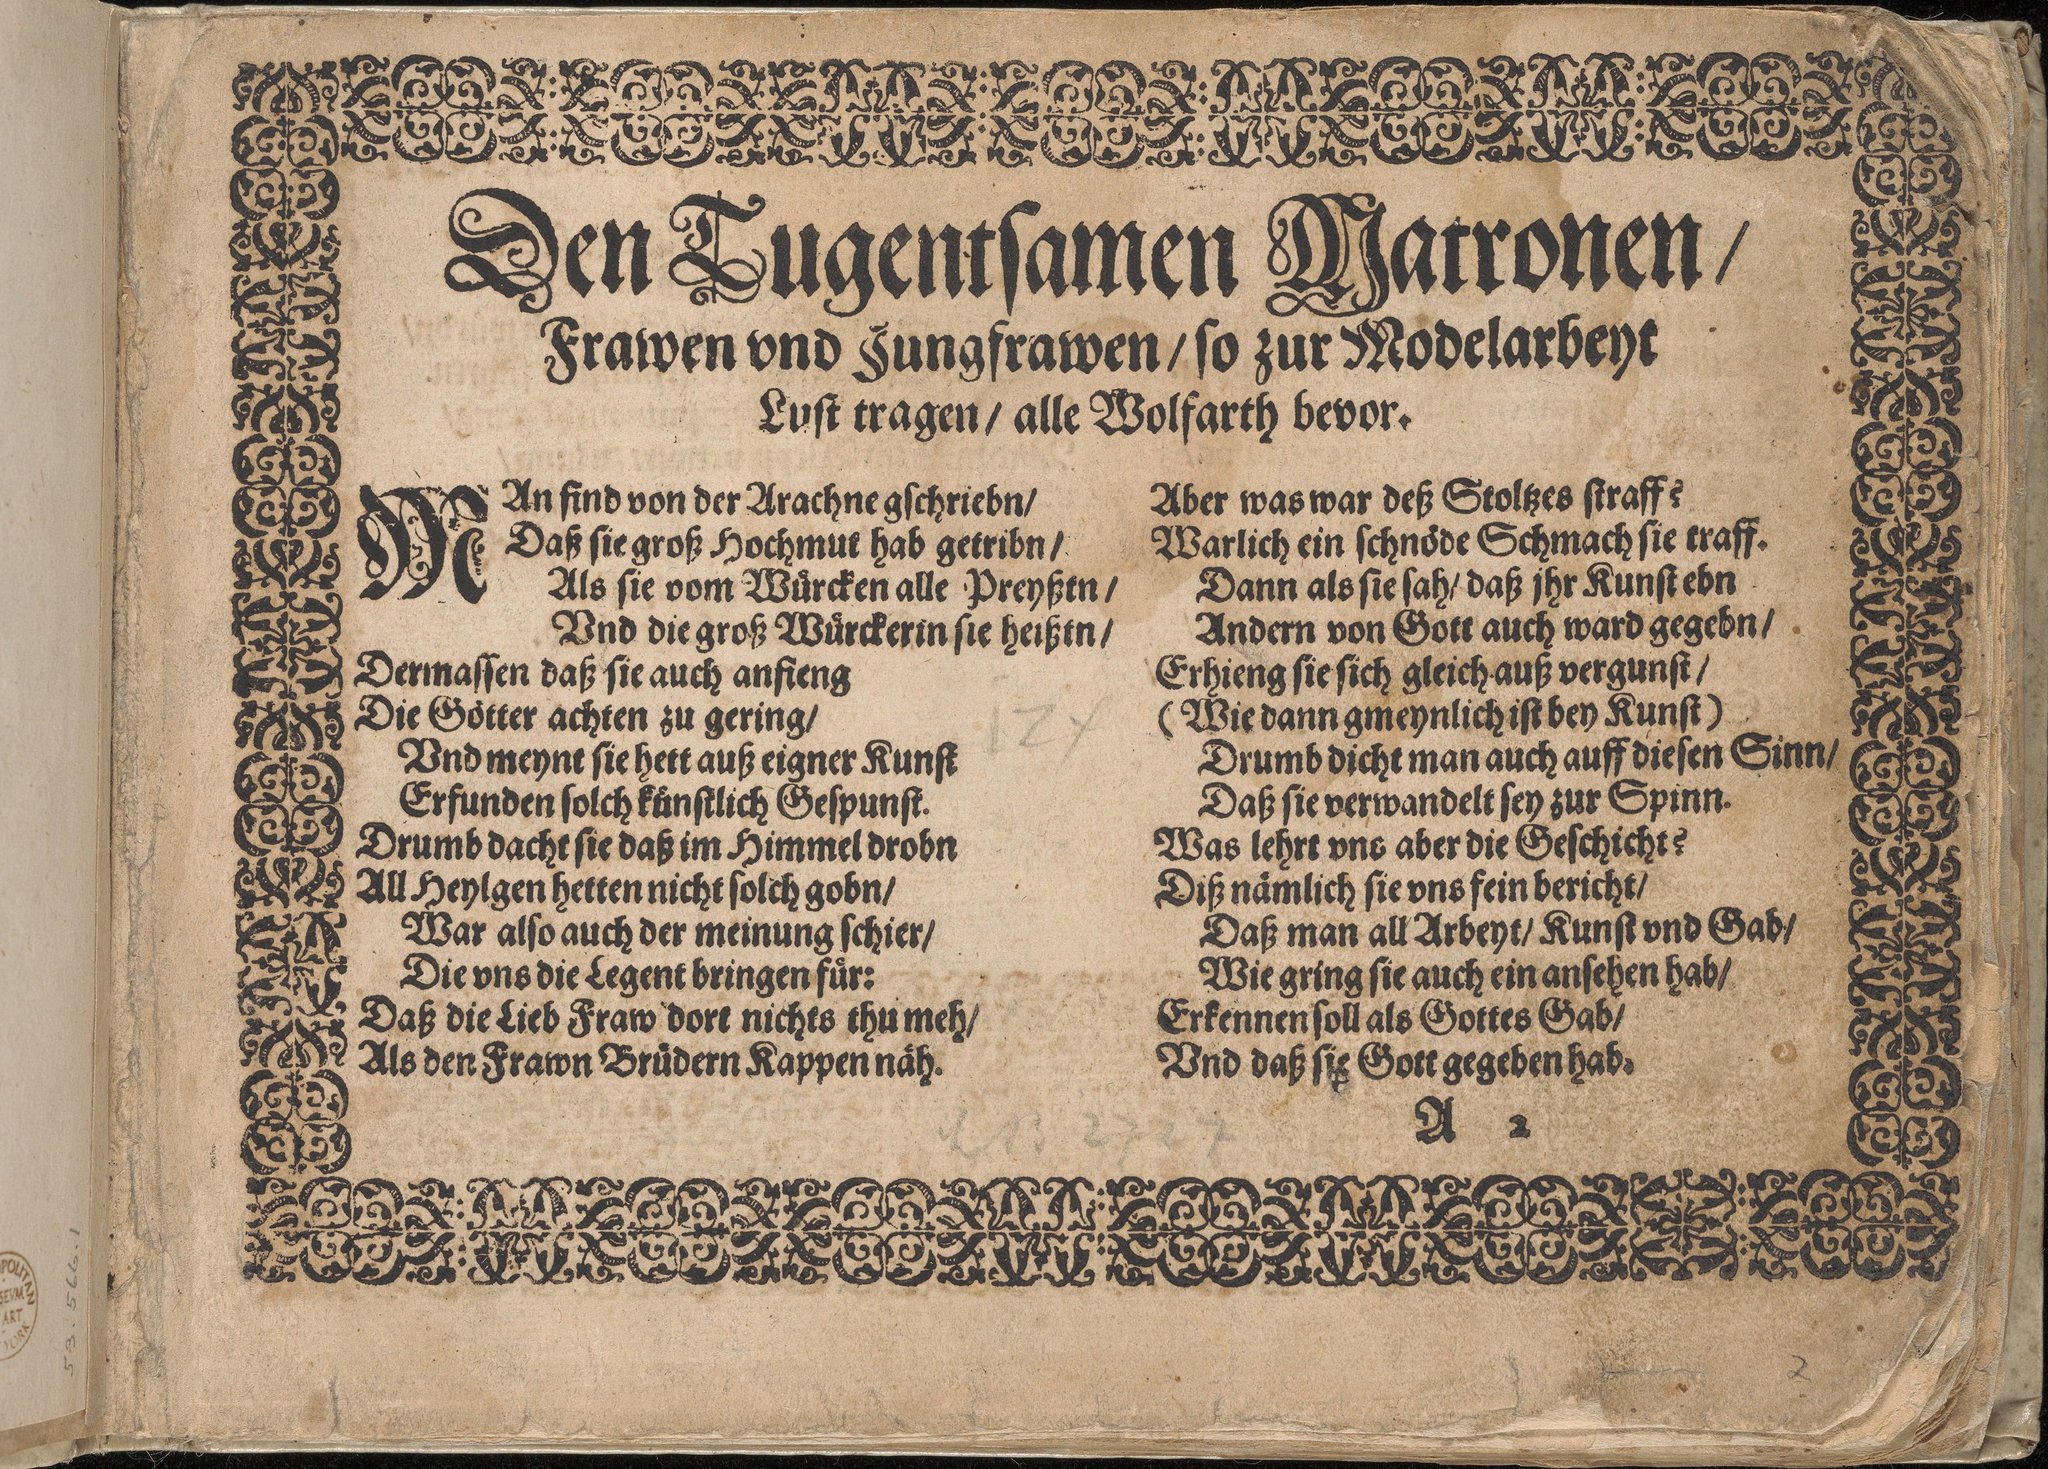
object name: ornament architecture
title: Dedication page of Neu künstlich Modelbuch (page 2r)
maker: bernhard jobin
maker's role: publisher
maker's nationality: swiss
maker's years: 1535-1597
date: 1598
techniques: woodcut